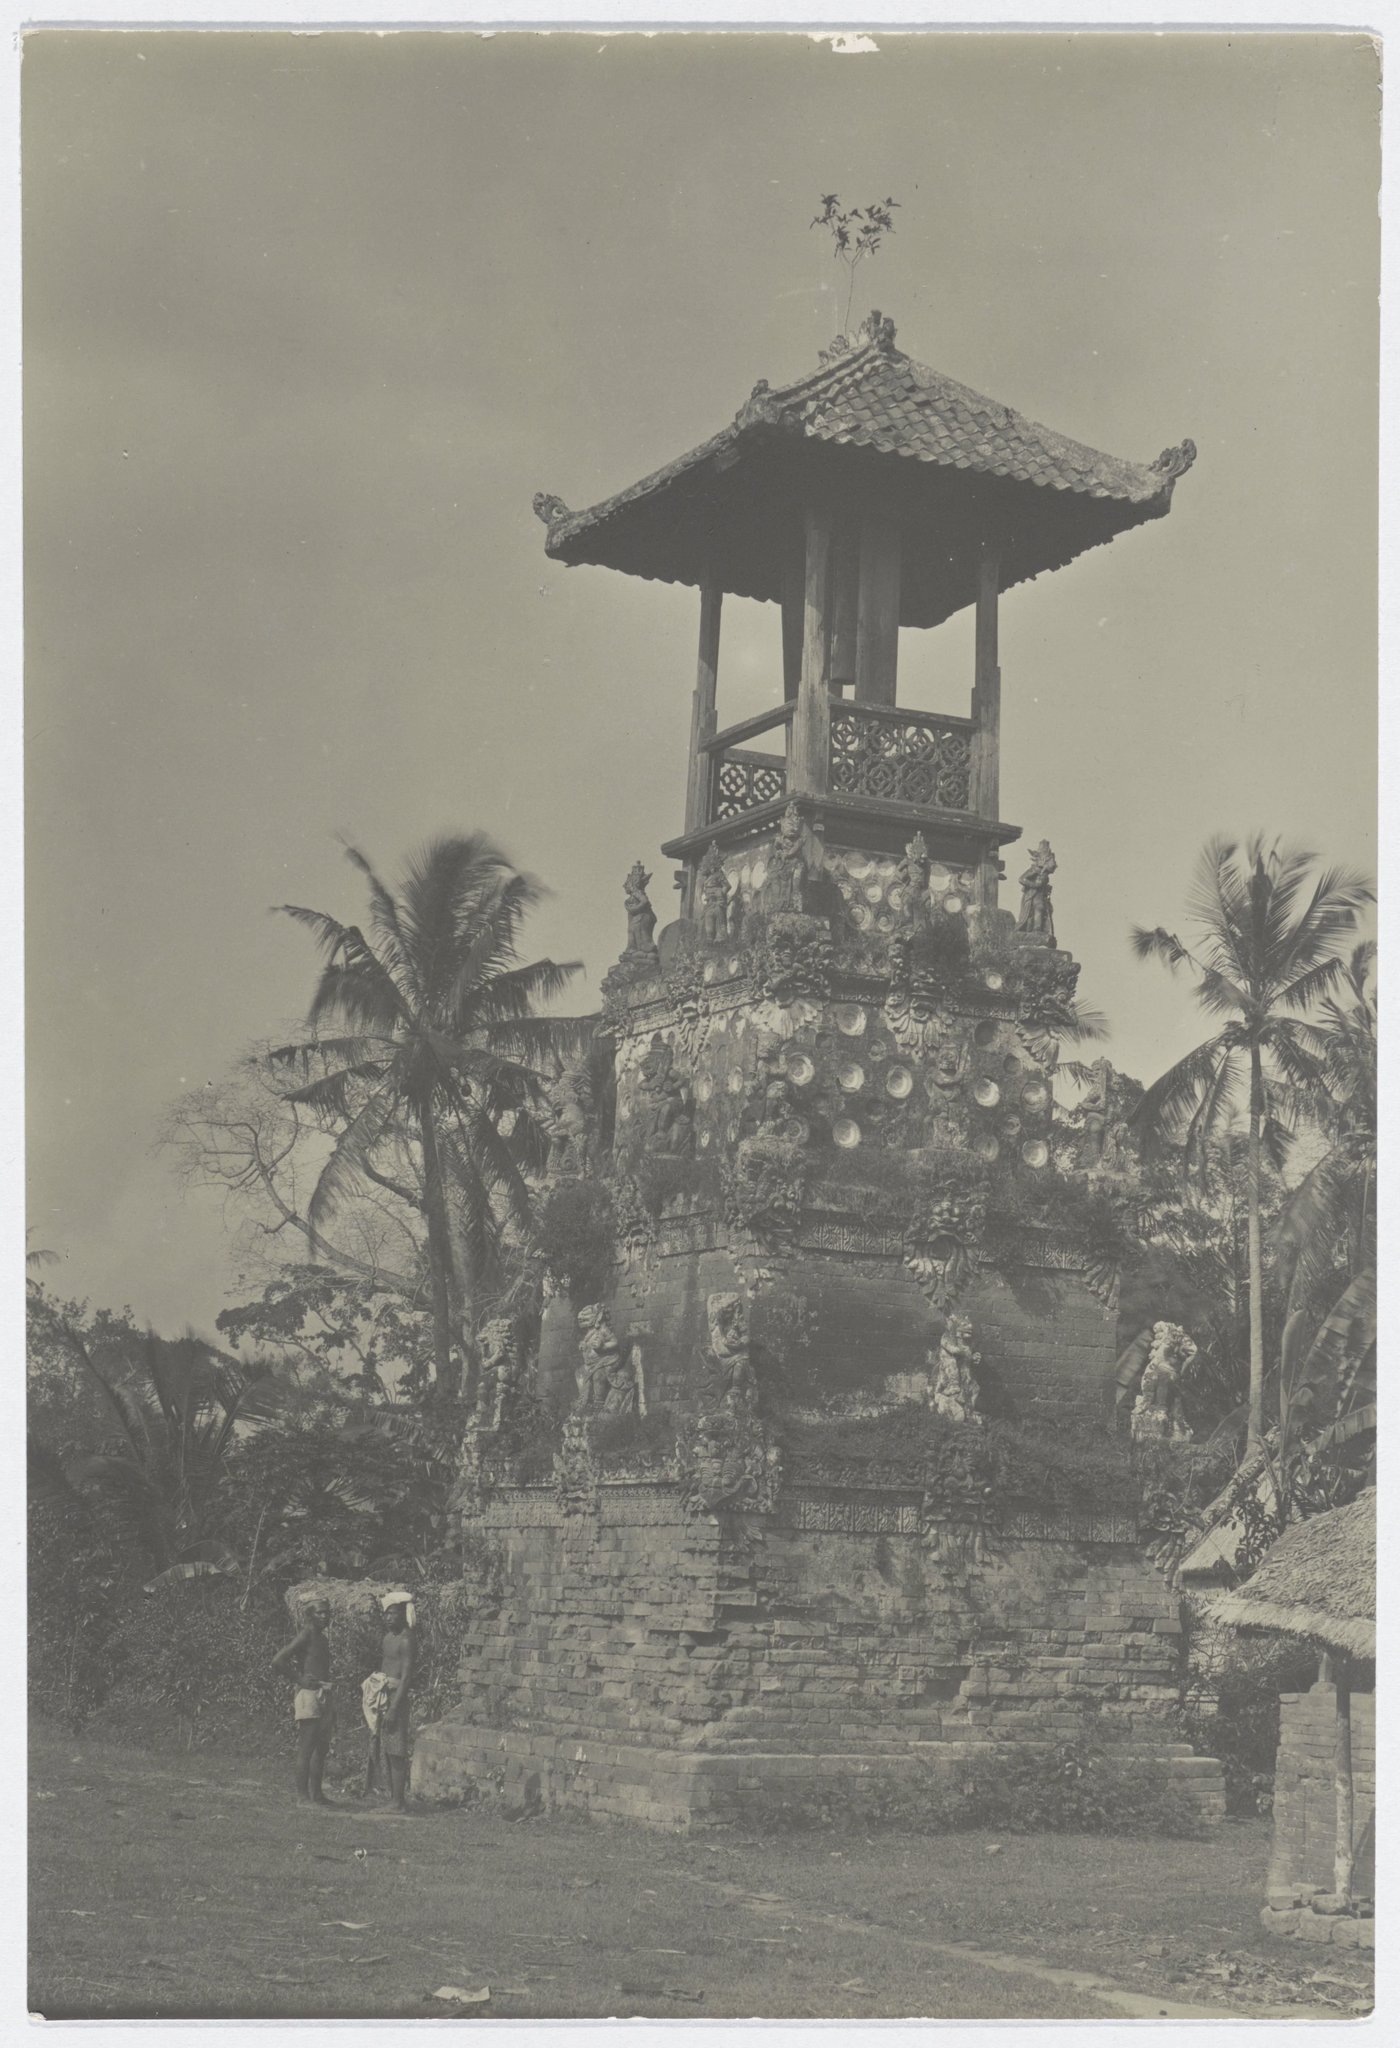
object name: photograph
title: Kleine tempel in de vorm van een toren met aan elke zijde van de vierkante tempel negen beelden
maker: Anonymous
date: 1890-1915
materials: cardboard, paper, photographic support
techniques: albumen print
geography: indonesia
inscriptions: title: ‘Tempeltje, men noemt dergel. tempeltjes, meen ik, Meroeh's’